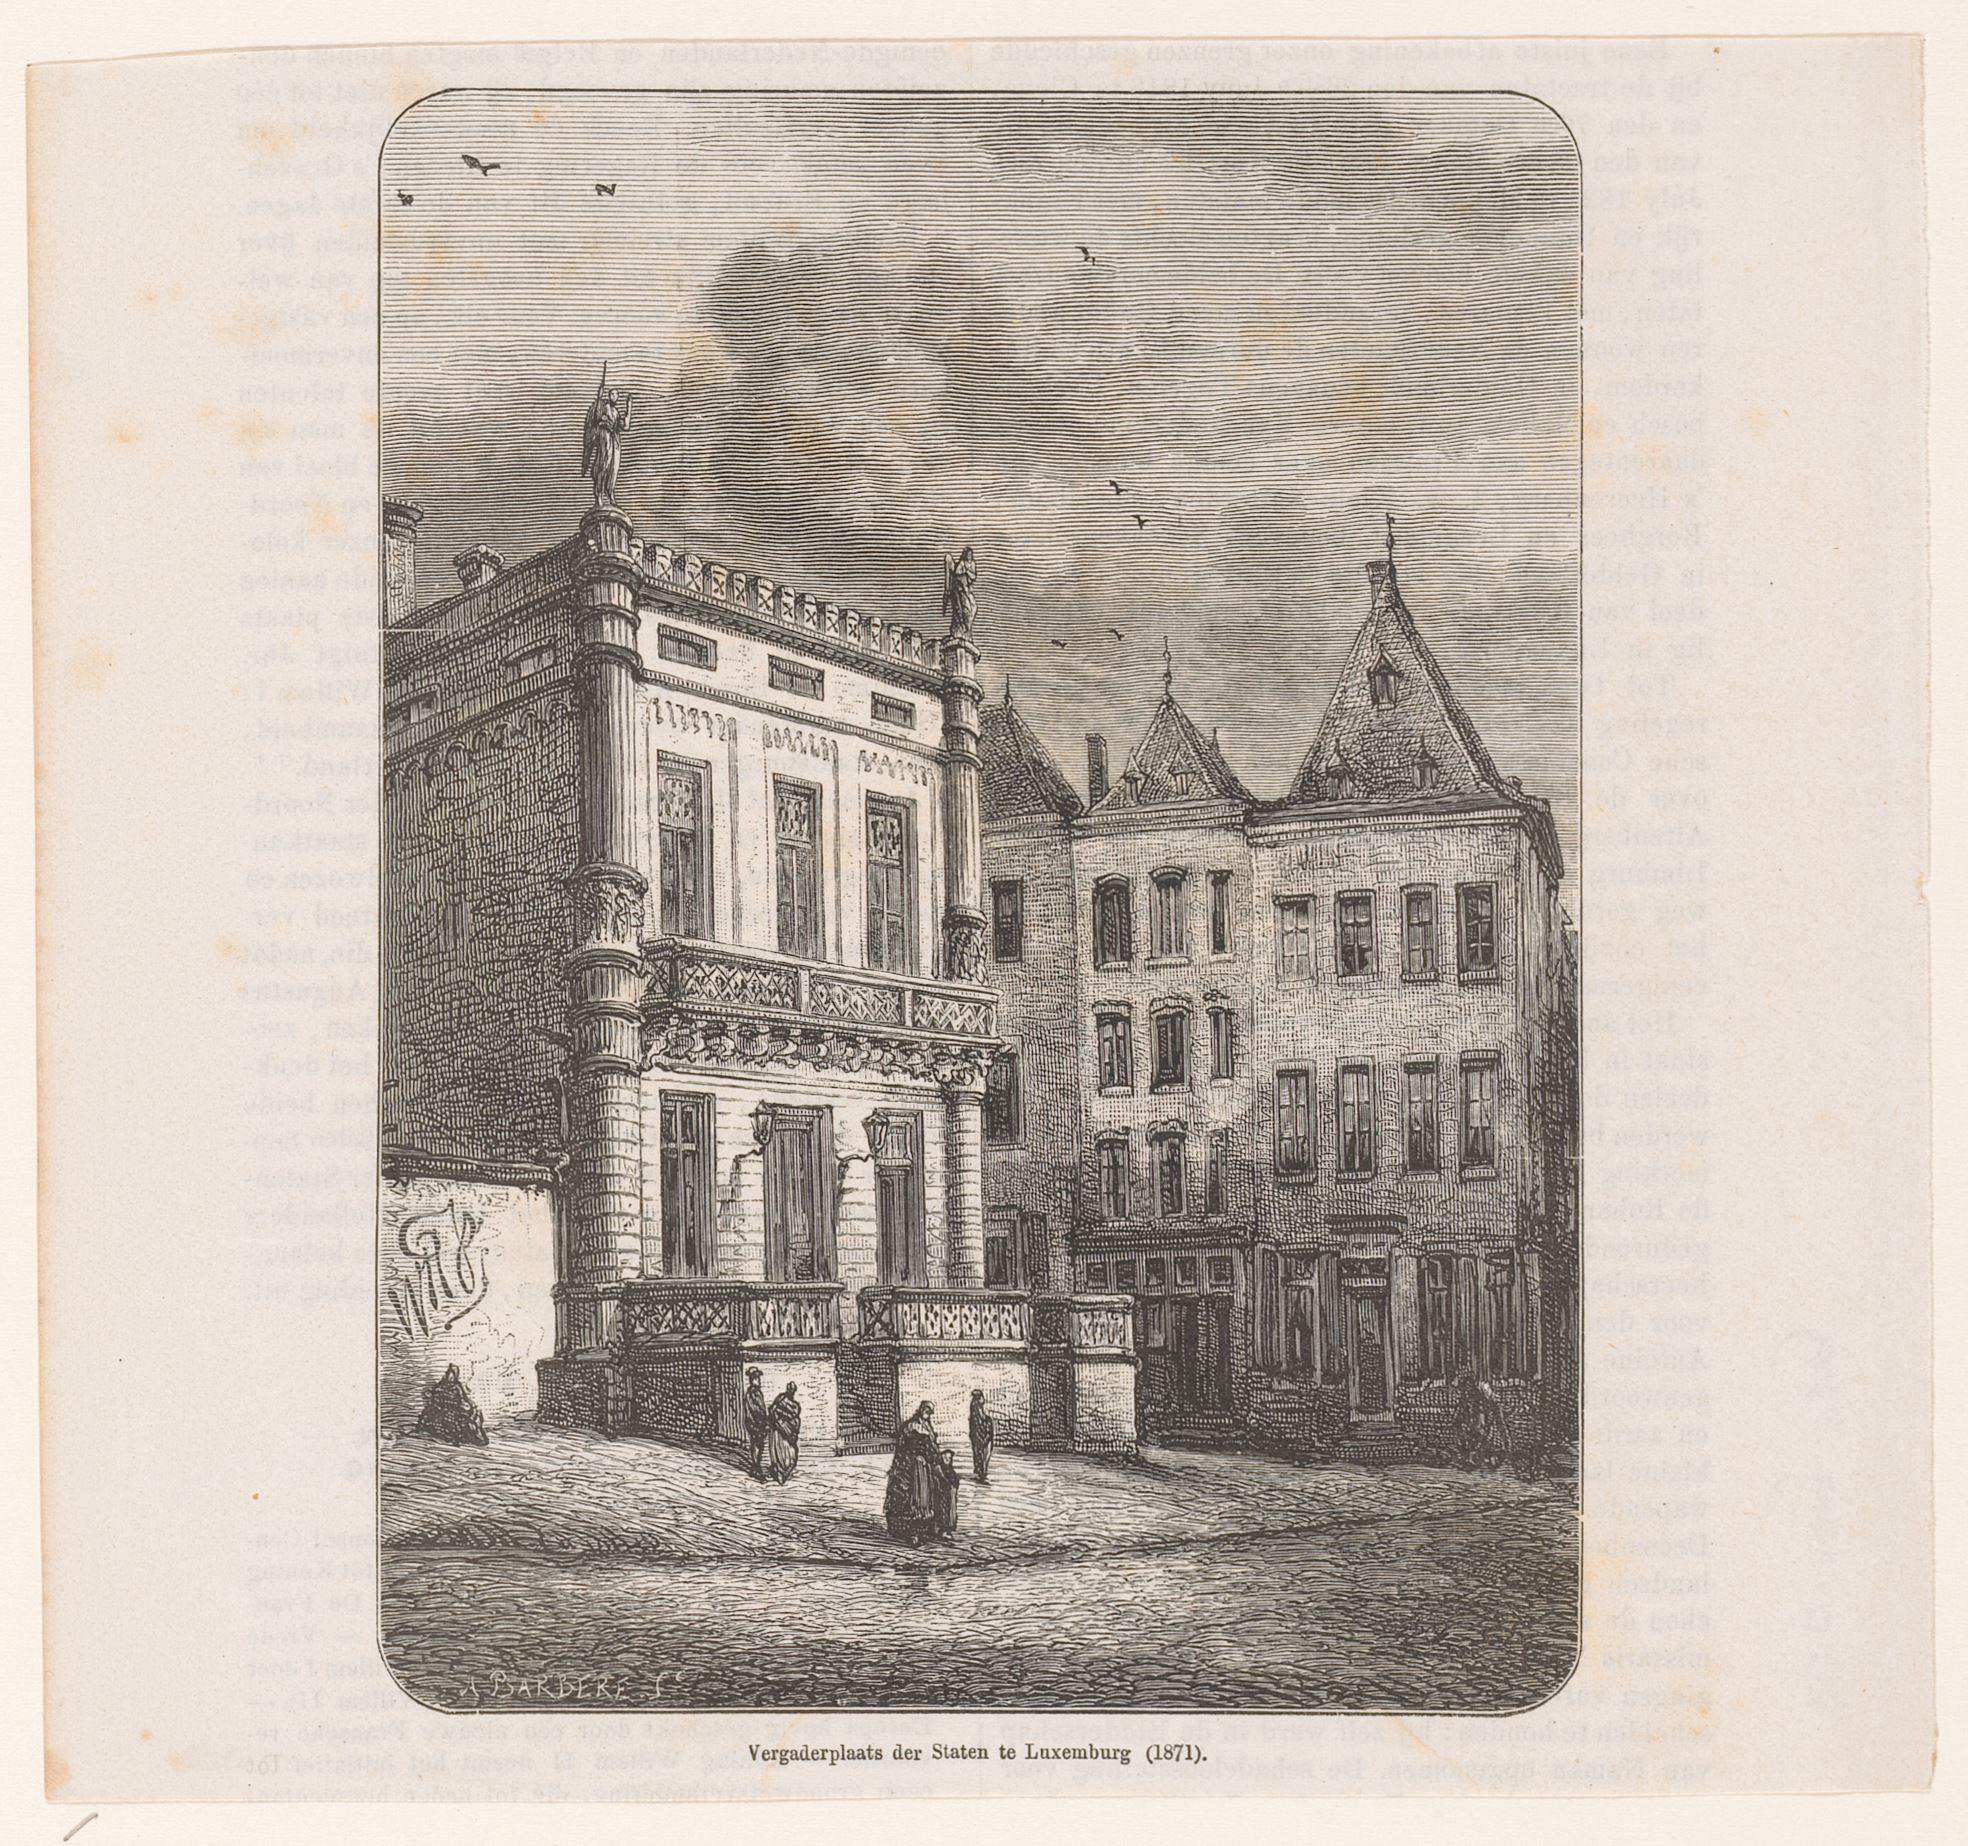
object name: print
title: Vergaderplaats der staten te Luxemburg (1871)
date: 1850-1899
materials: paper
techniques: letterpress printing, engraving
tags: national government